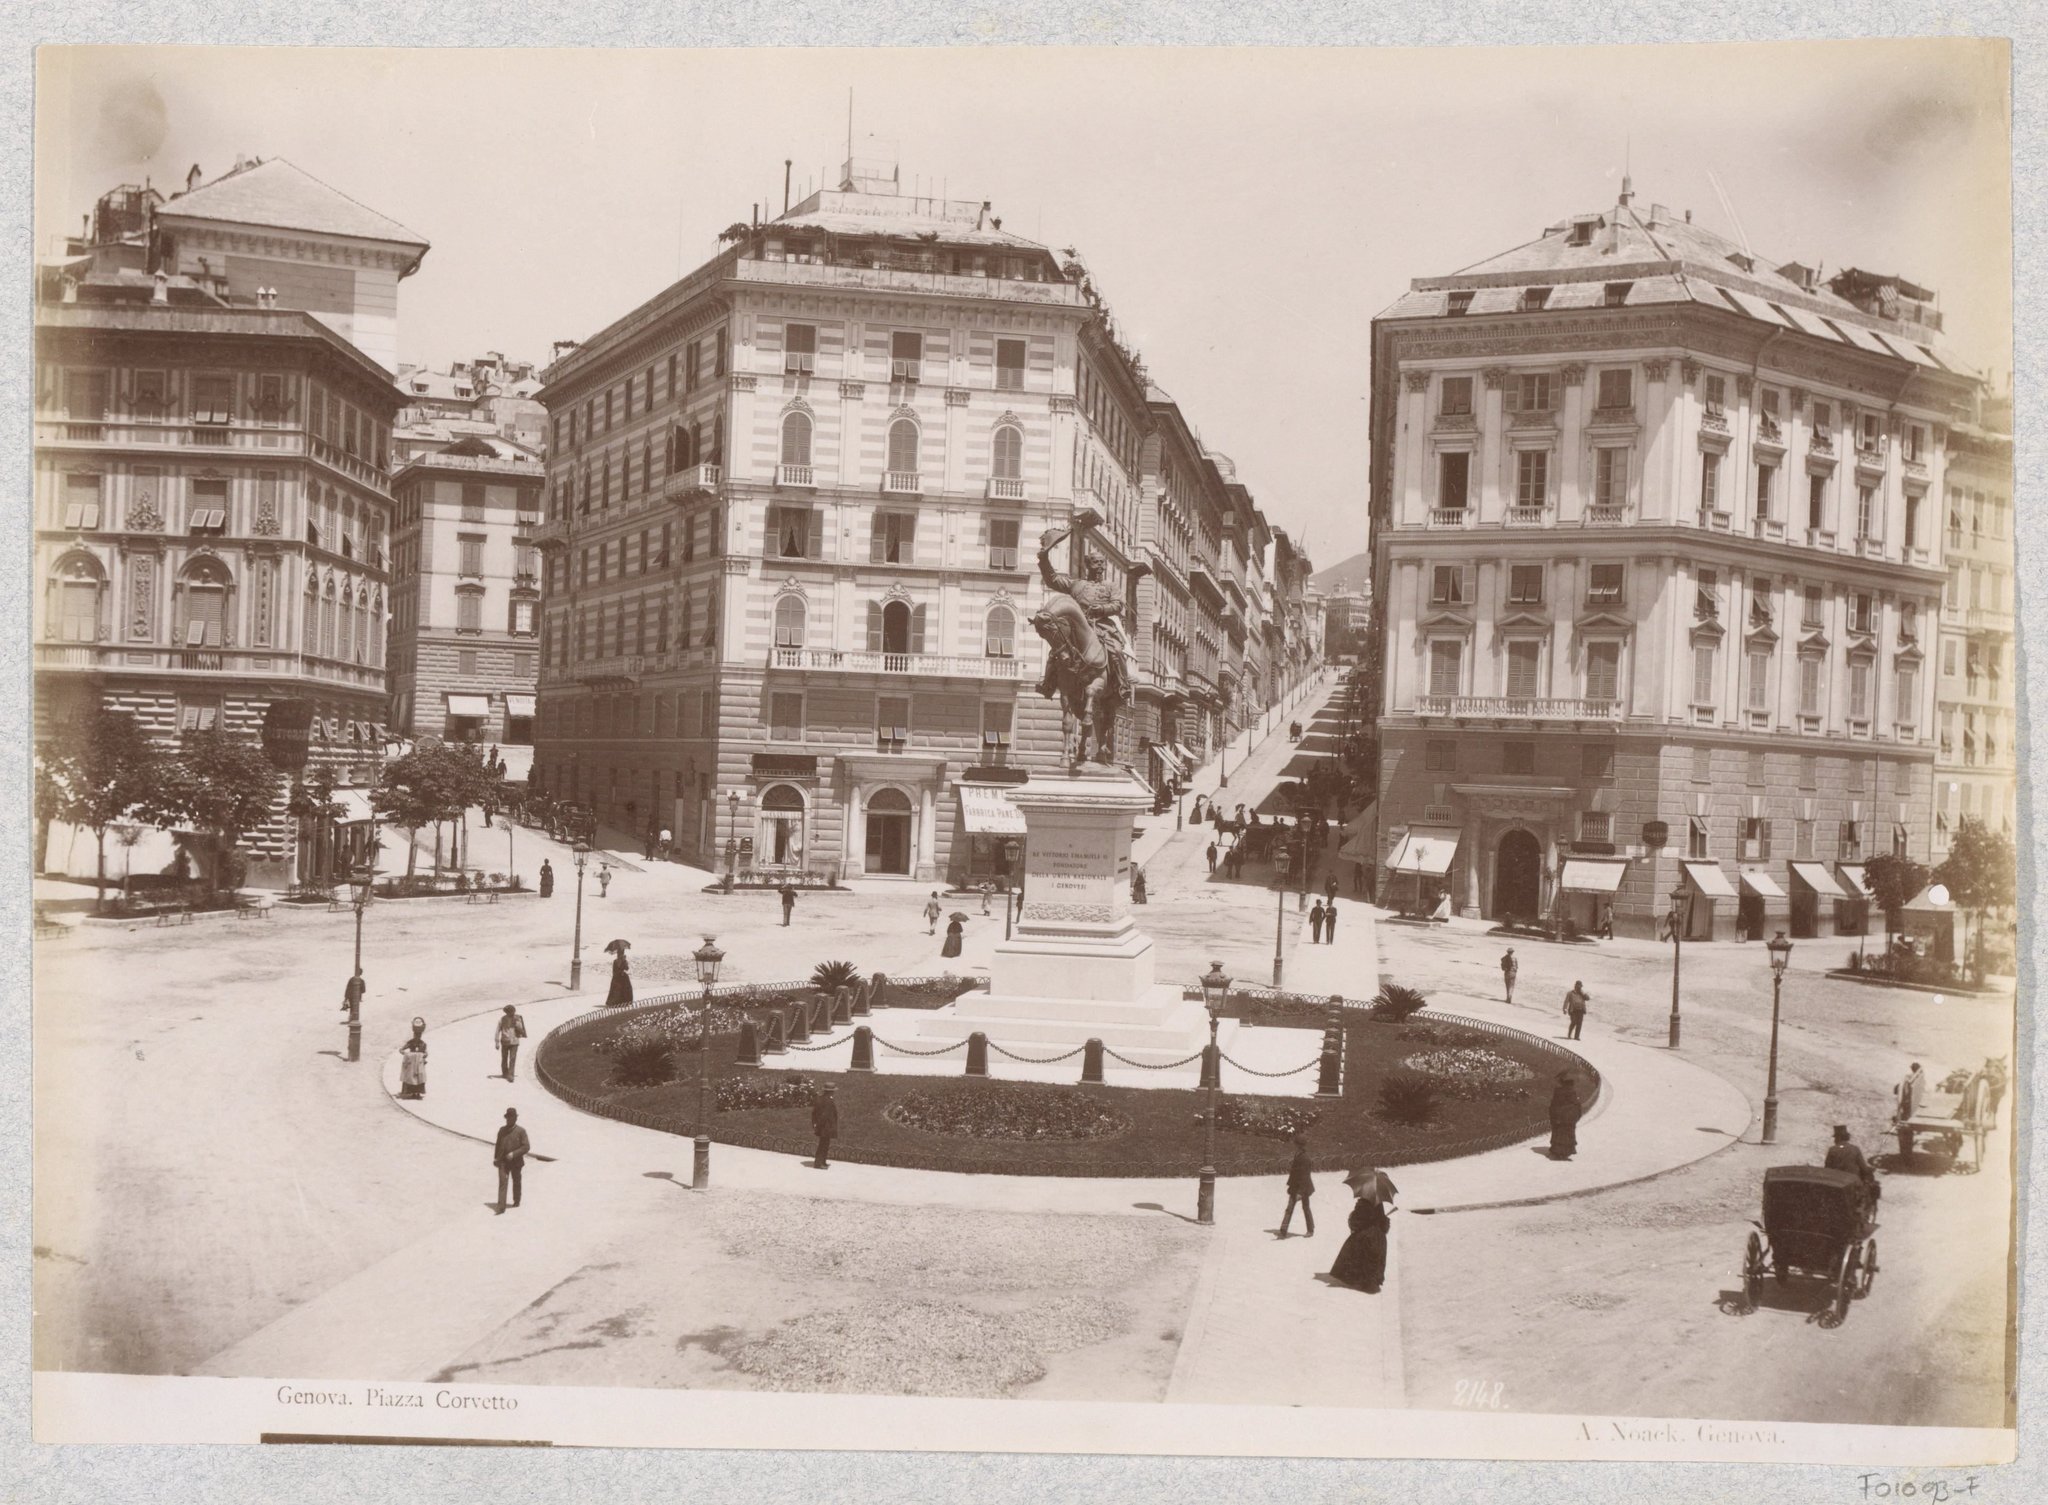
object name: photograph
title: Genova. Piazza Corvetto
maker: alfredo noack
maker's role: fotograaf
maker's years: 1833-1895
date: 1870-1890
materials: paper, photographic support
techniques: albumen print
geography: genoa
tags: equestrian statue, square, place, circus, etc. (+ city(-scape) with figures, staffage)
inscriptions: negative number: ‘2148’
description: Onderdeel van Reisalbum met foto's van bezienswaardigheden in Genua, Florence en Venetië.